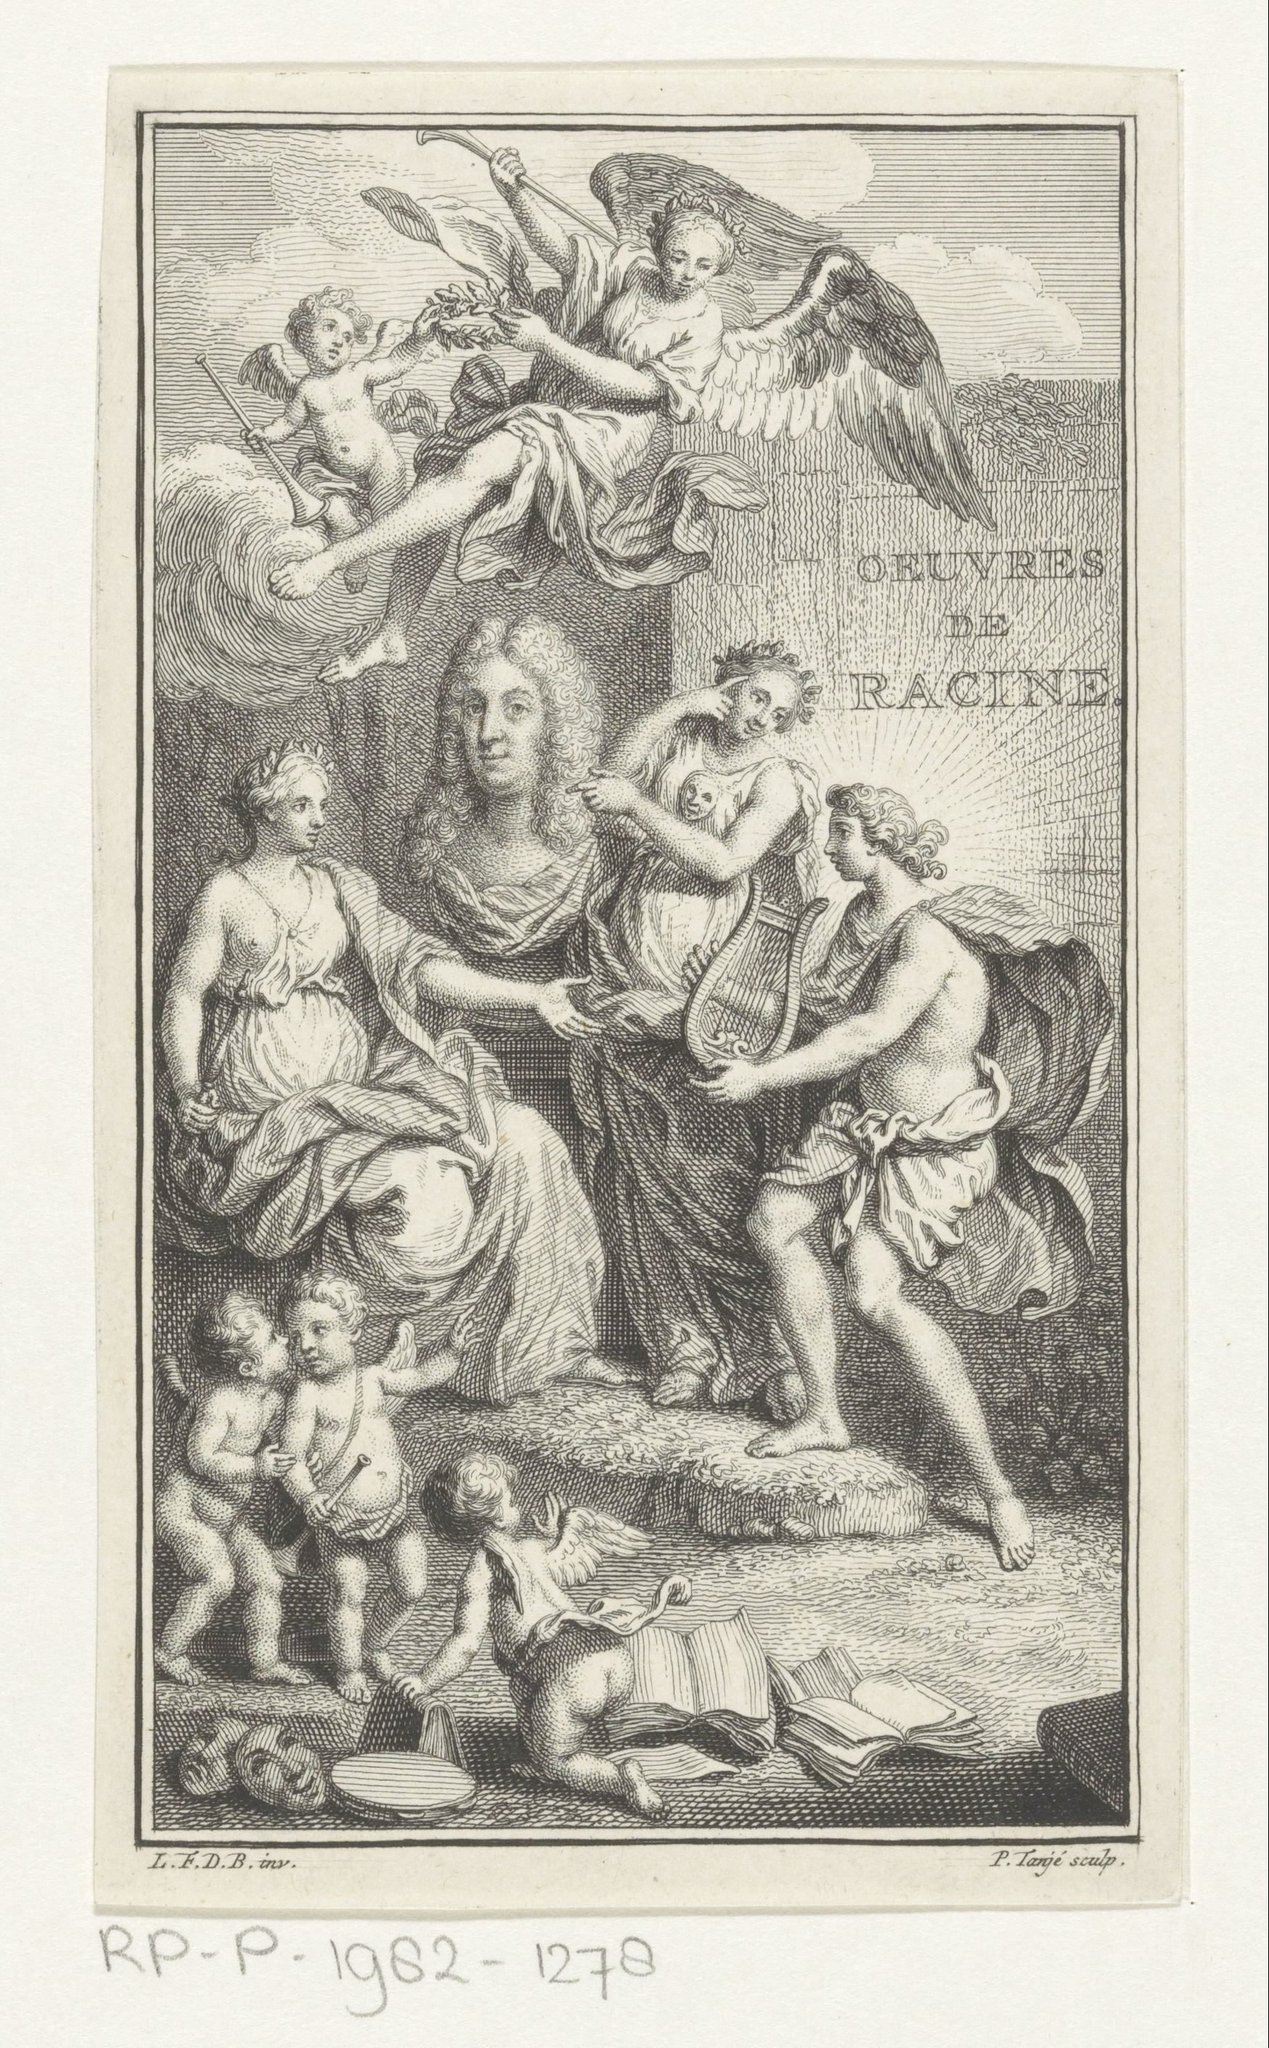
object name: print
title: Portret van Jean Baptiste Racine met een muze en Apollo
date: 1763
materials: paper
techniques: engraving, etching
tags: france, paris, jean racine, (story of) apollo (phoebus), portrait of a writer, fame; 'fama', 'fama buona', 'fama chiara' (ripa), single muses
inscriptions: collector's mark: Lugt 2228, collector's mark: Lugt 2760, stamp: ‘CR’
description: Bij de portretbuste van toneelschrijver Jean Baptiste Racine zit een muze, die de lier van Apollo ontvangt. Tussen hen in staat Verstand, die op haar hoofd wijst. Faam komt aanvliegen met een lauwerkrans. Op de voorgrond spelen putti met theaterattributen.